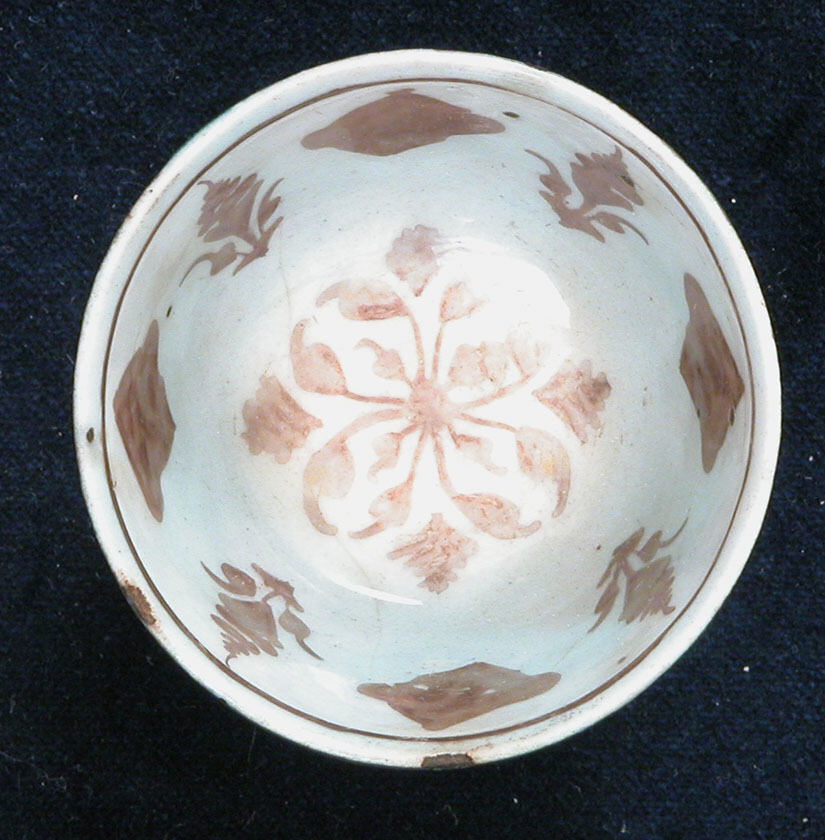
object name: cup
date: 1601-1700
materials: glaze, silver, stonepaste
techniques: luster painting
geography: iran